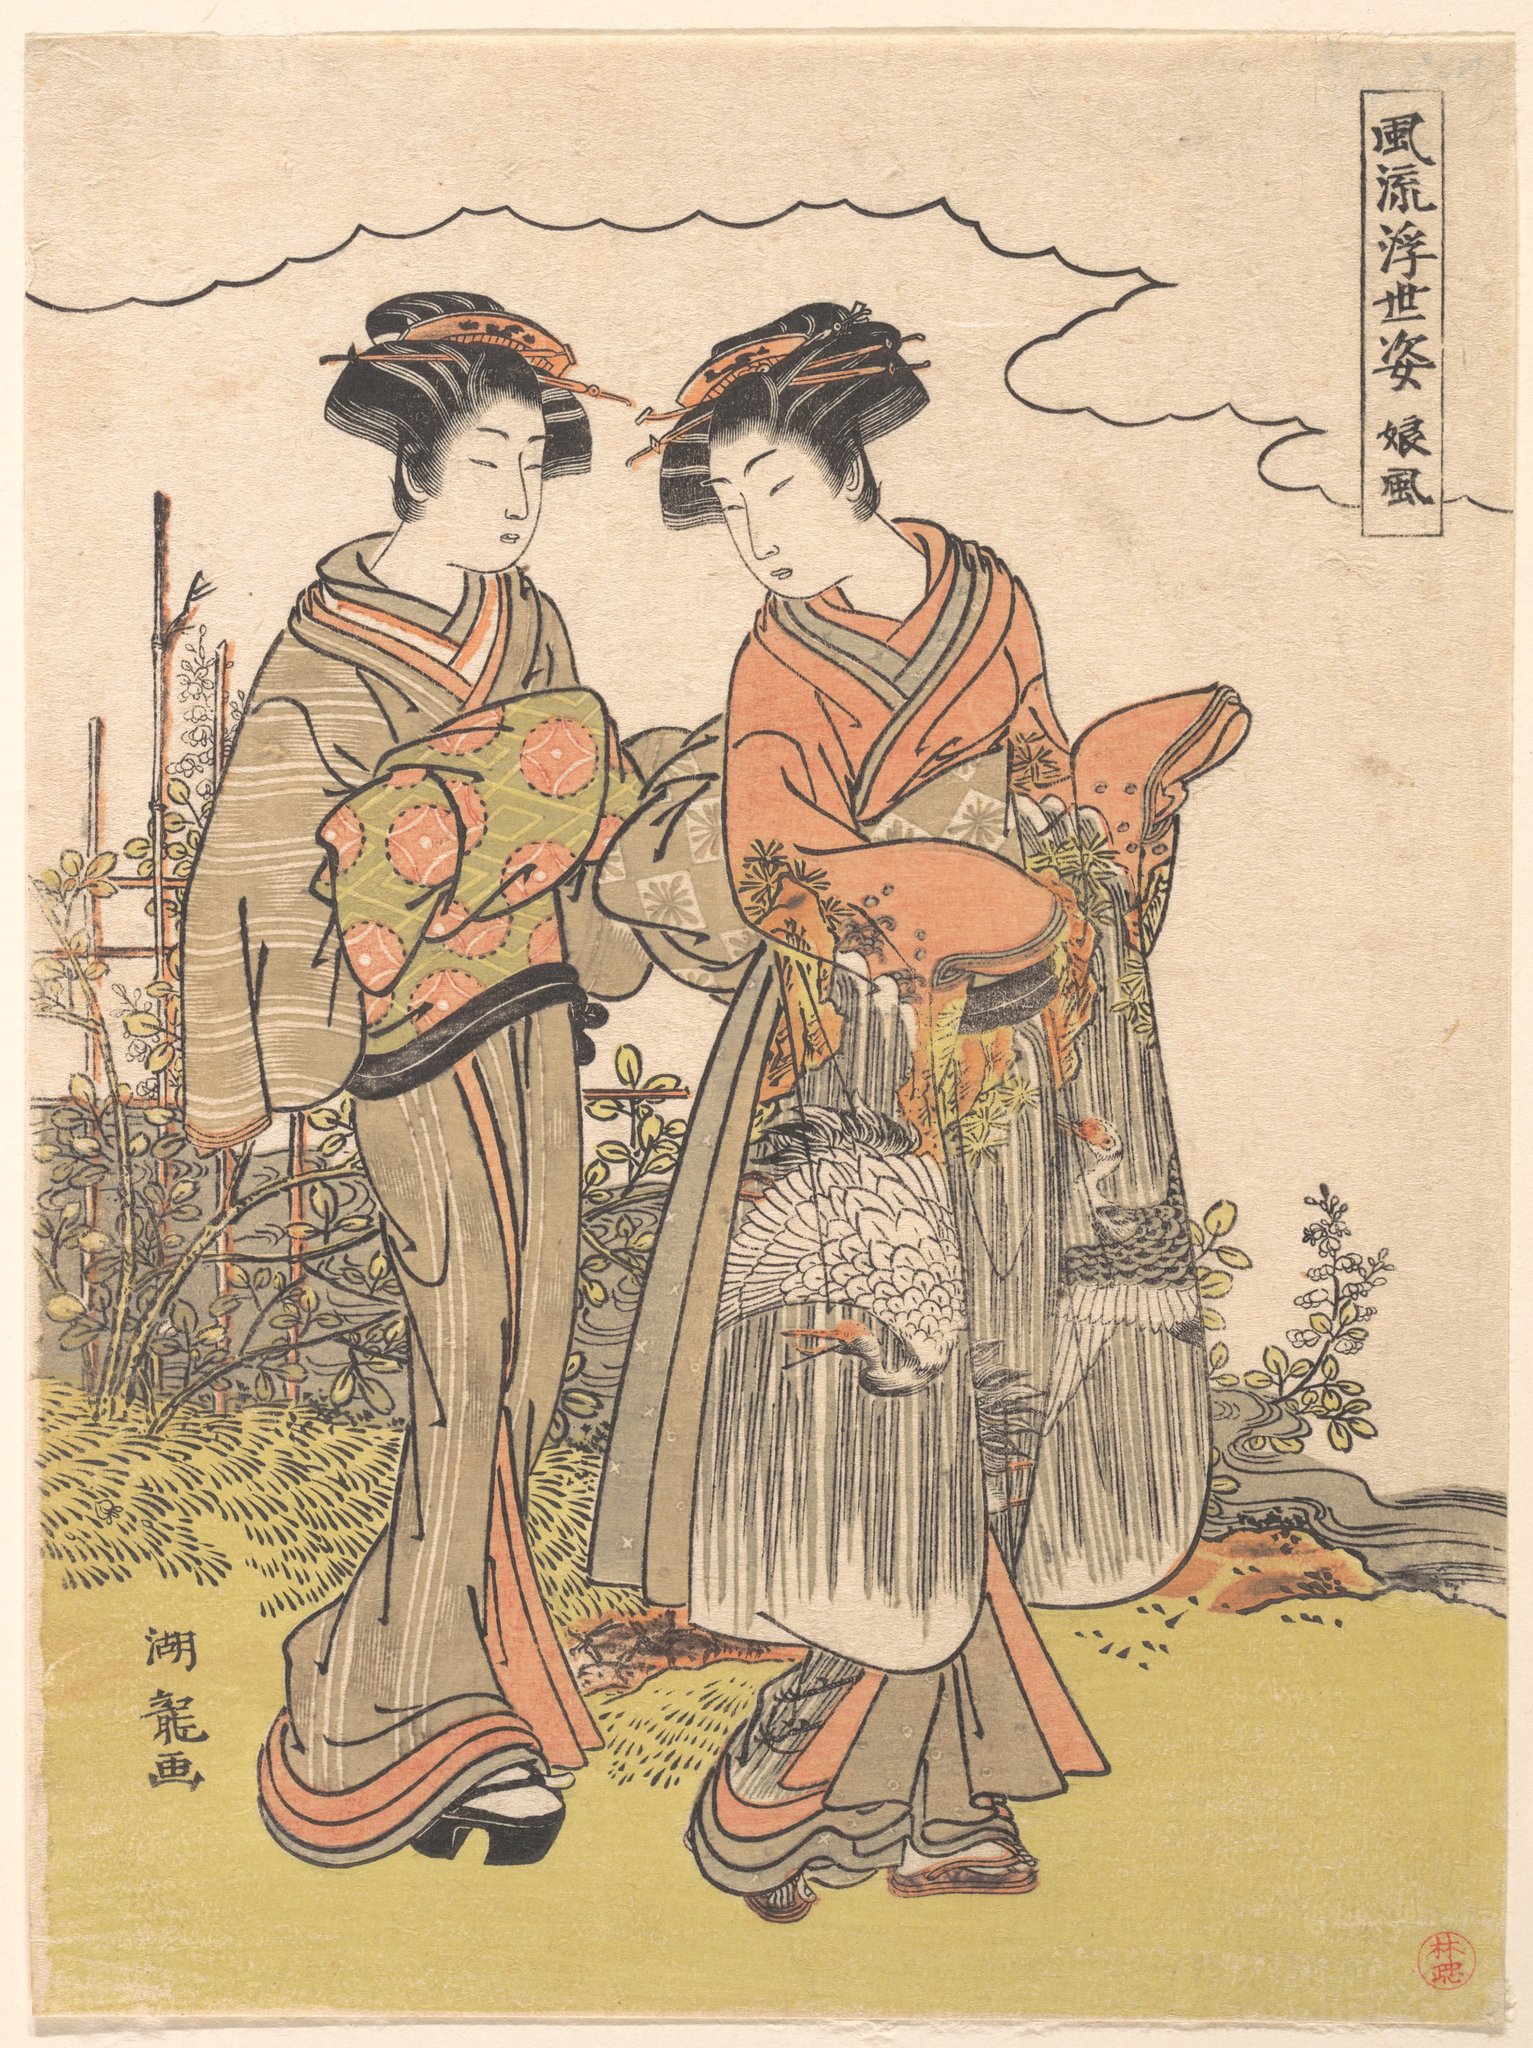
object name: print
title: Girl Accompanied by an Elder Attendant Walking by a Stream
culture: japanese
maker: isoda koryūsai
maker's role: artist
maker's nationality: japanese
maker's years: 1735-1790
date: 1770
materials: ink, paper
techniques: woodblock print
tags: girls,plants